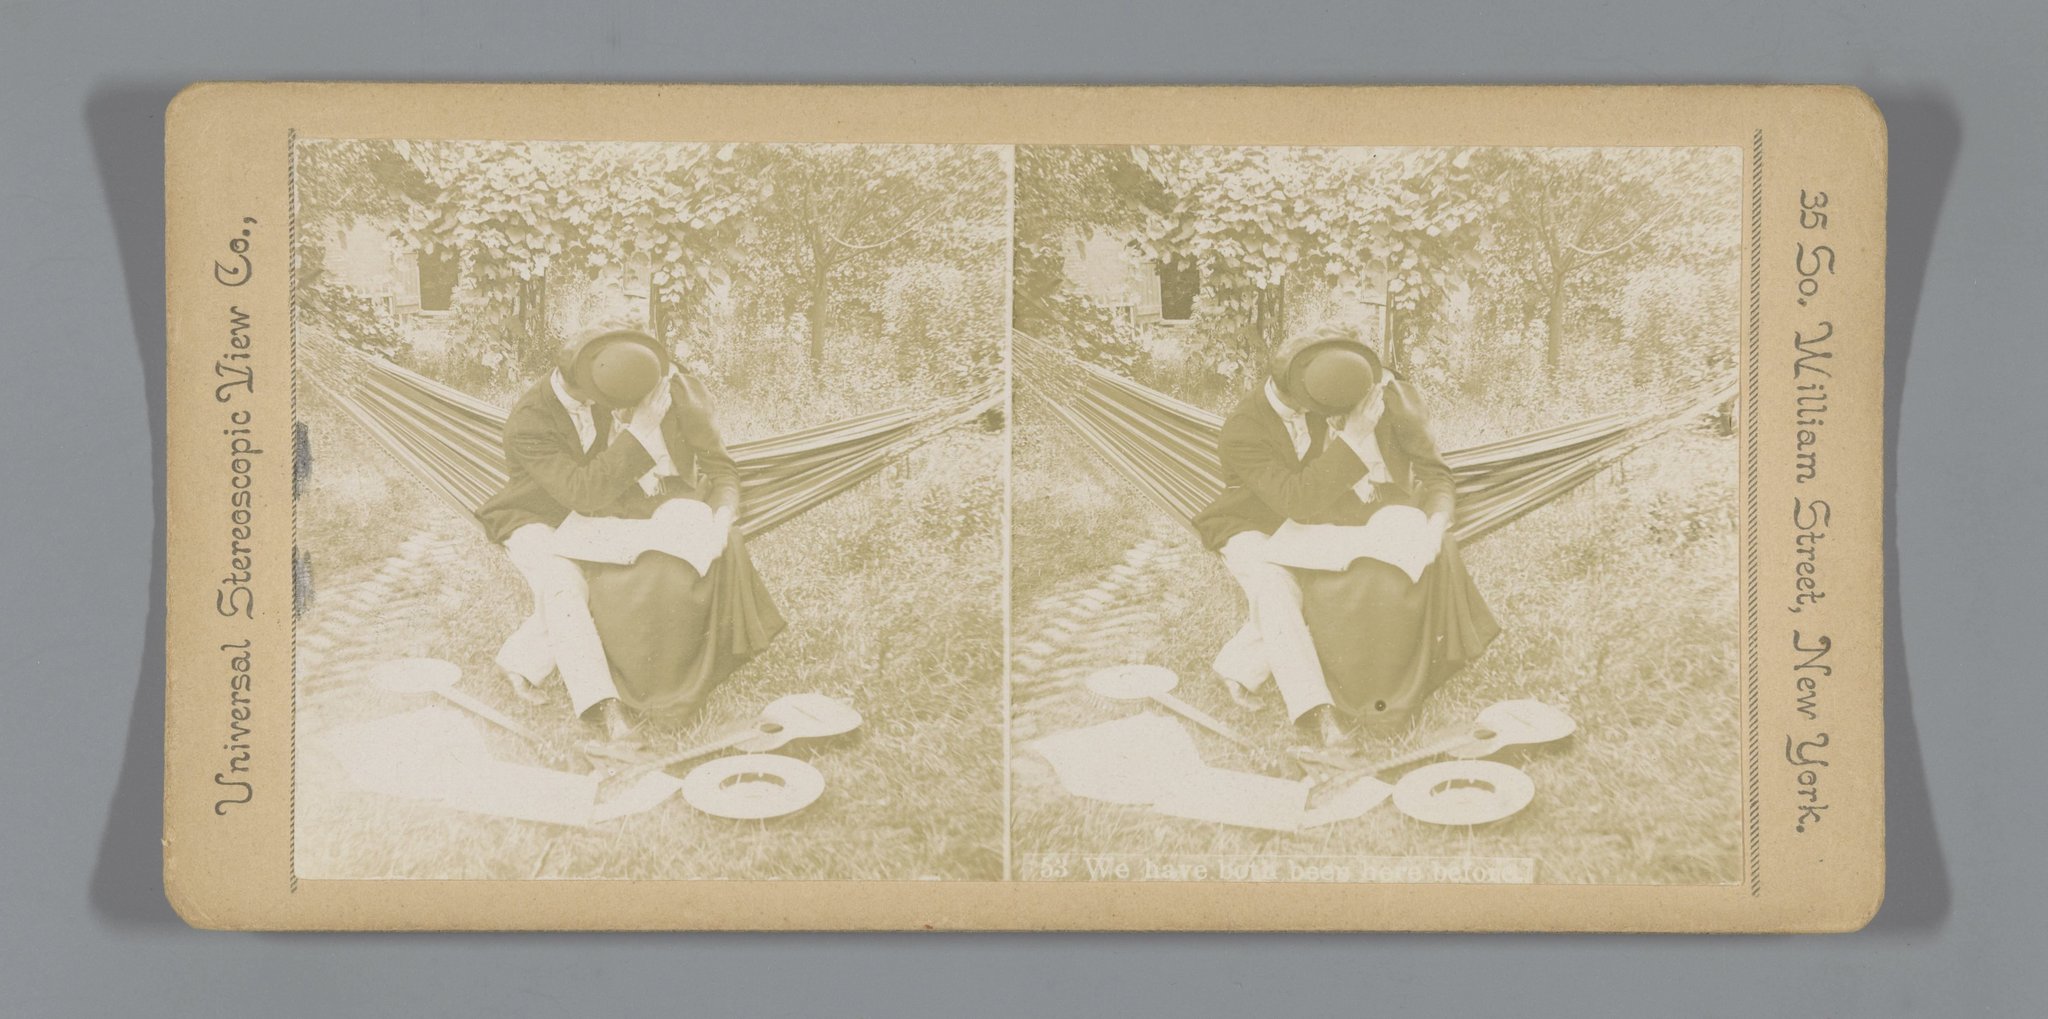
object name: photograph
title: Paar zittend in hangmat verscholen achter hoed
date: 1890-1910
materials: cardboard, photographic support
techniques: gelatin silver print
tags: hammock, cithern, mandolin, guitar, balalaika - cc - out of doors, head-gear: hat, couple of lovers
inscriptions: number: ‘39’, : ‘35 So. William Street, New York’, number: ‘53’